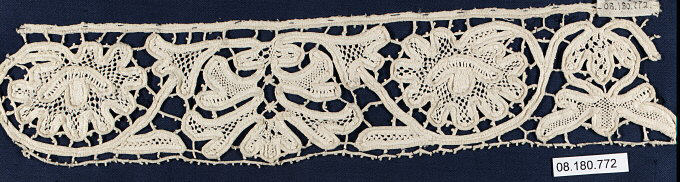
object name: fragment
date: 1601-1700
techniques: lace